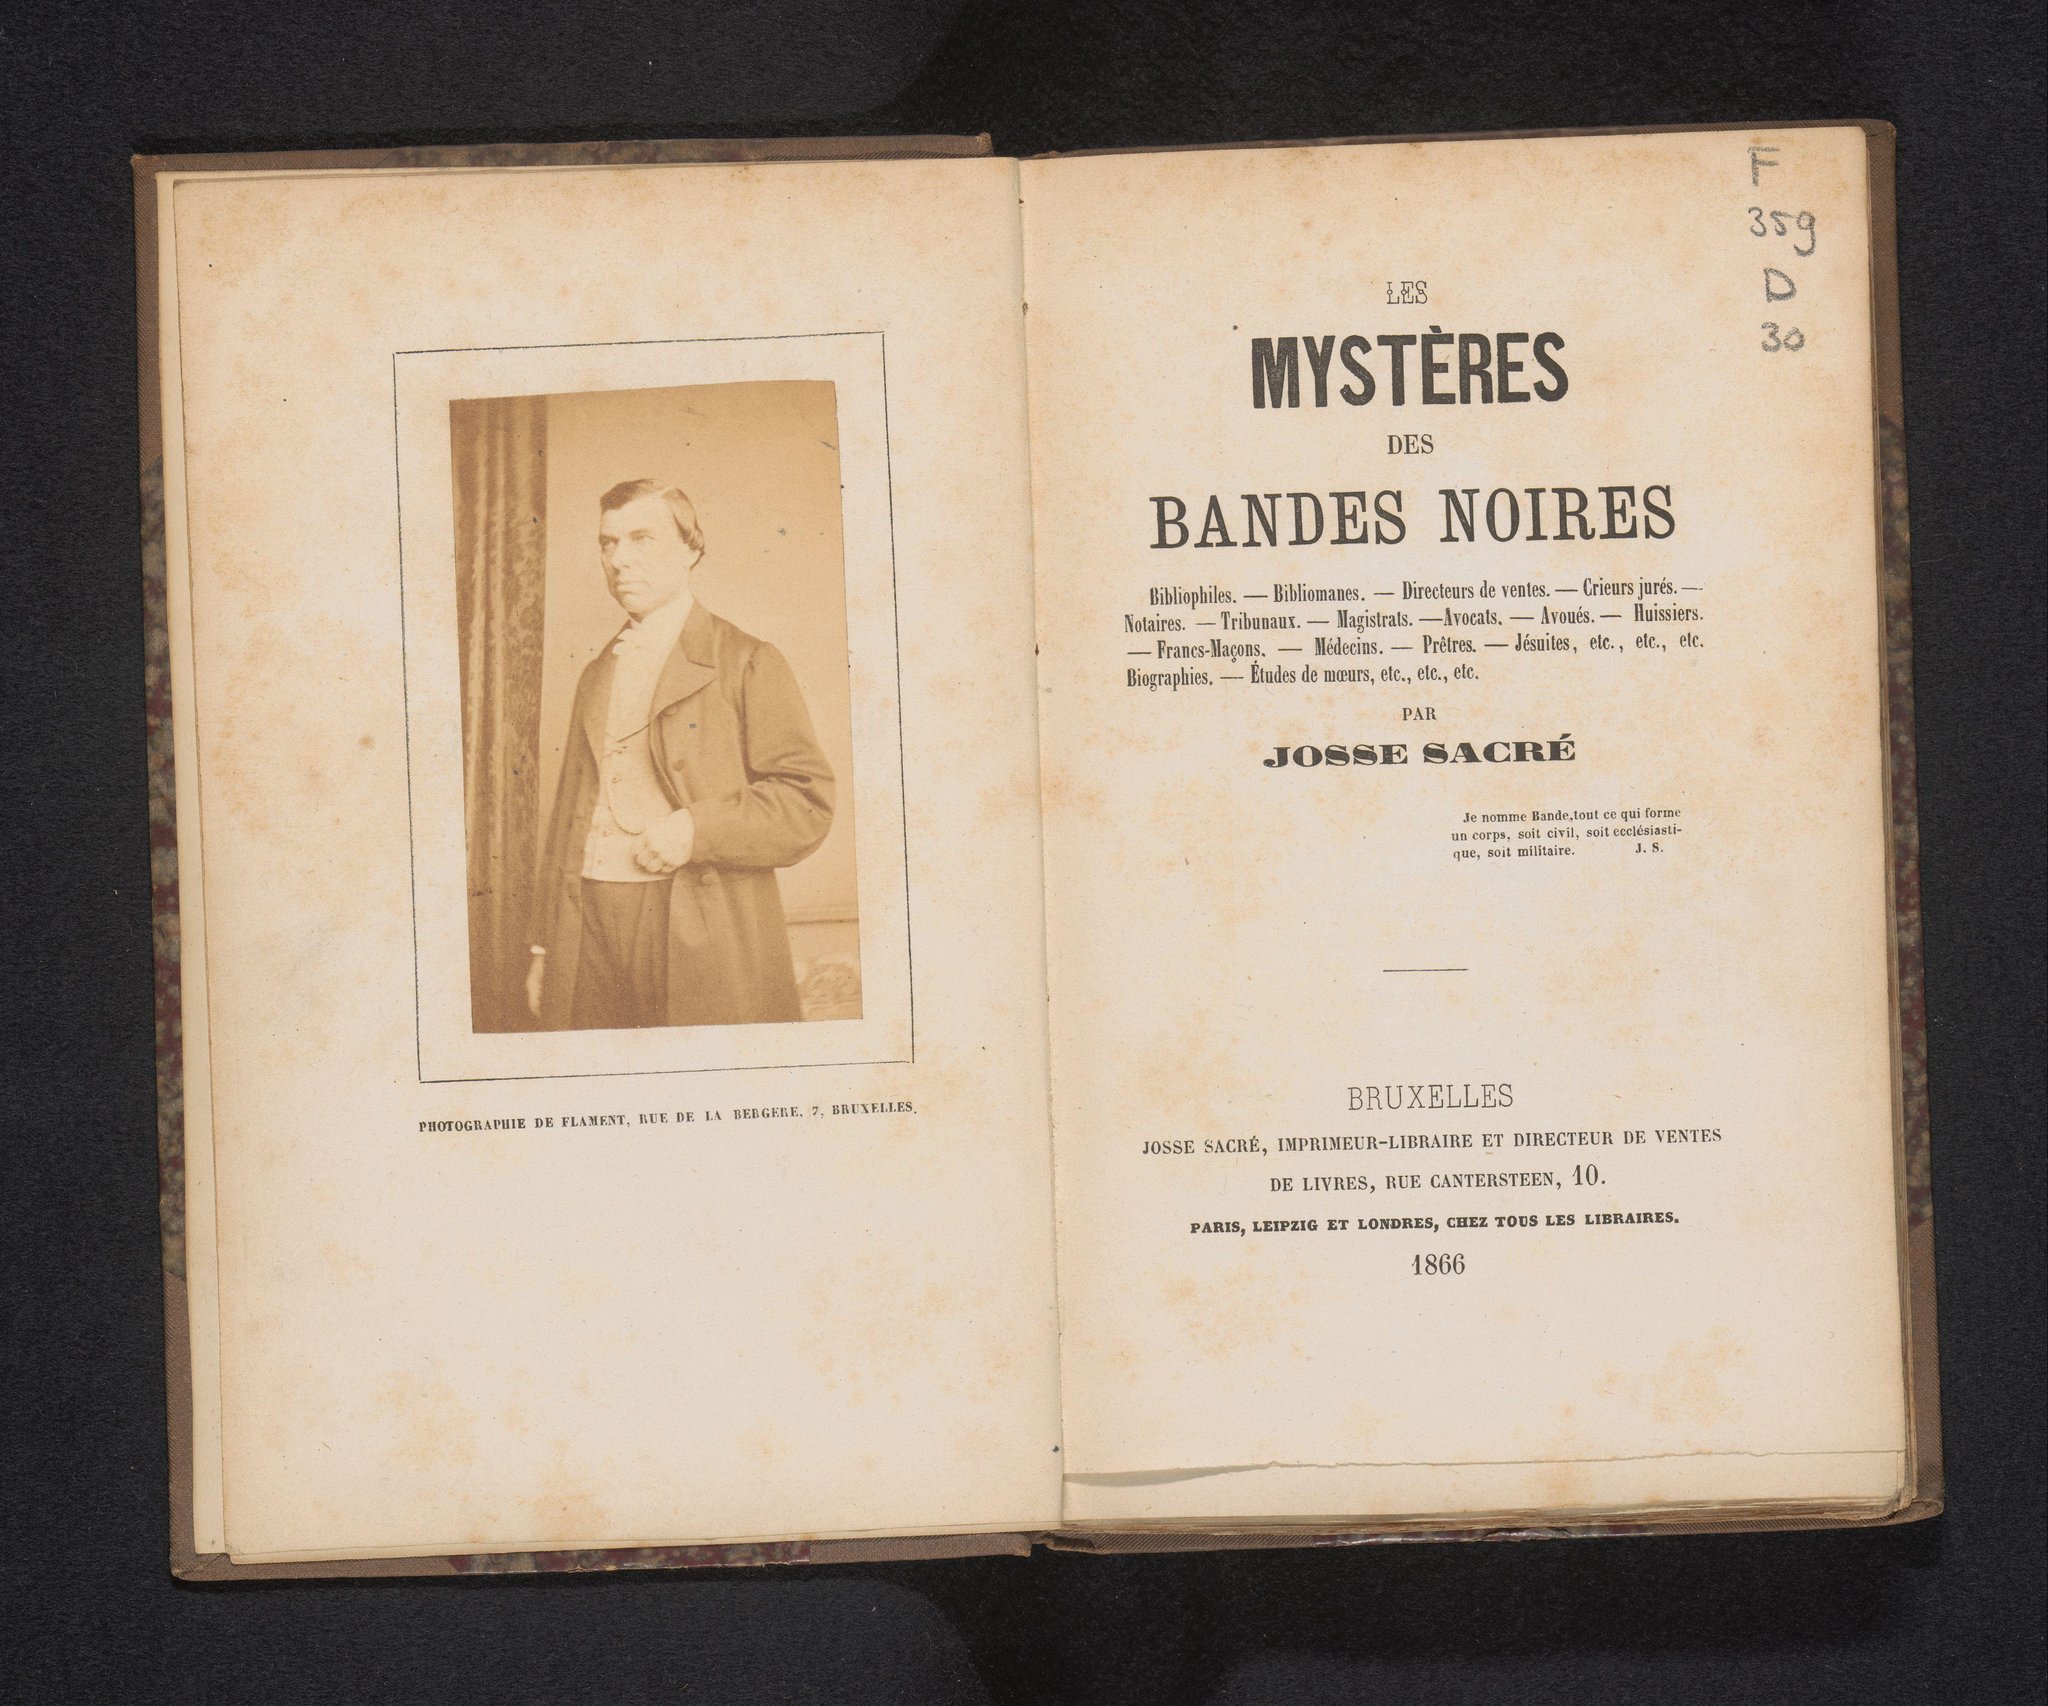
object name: photograph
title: Portret van Josse Sacré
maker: Anonymous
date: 1861-1866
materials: photographic support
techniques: albumen print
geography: brussels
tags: publisher, josse sacré, historical persons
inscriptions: inscription: ‘Photographie de Flament, Rue de la Bergere, 7, Bruxelles’